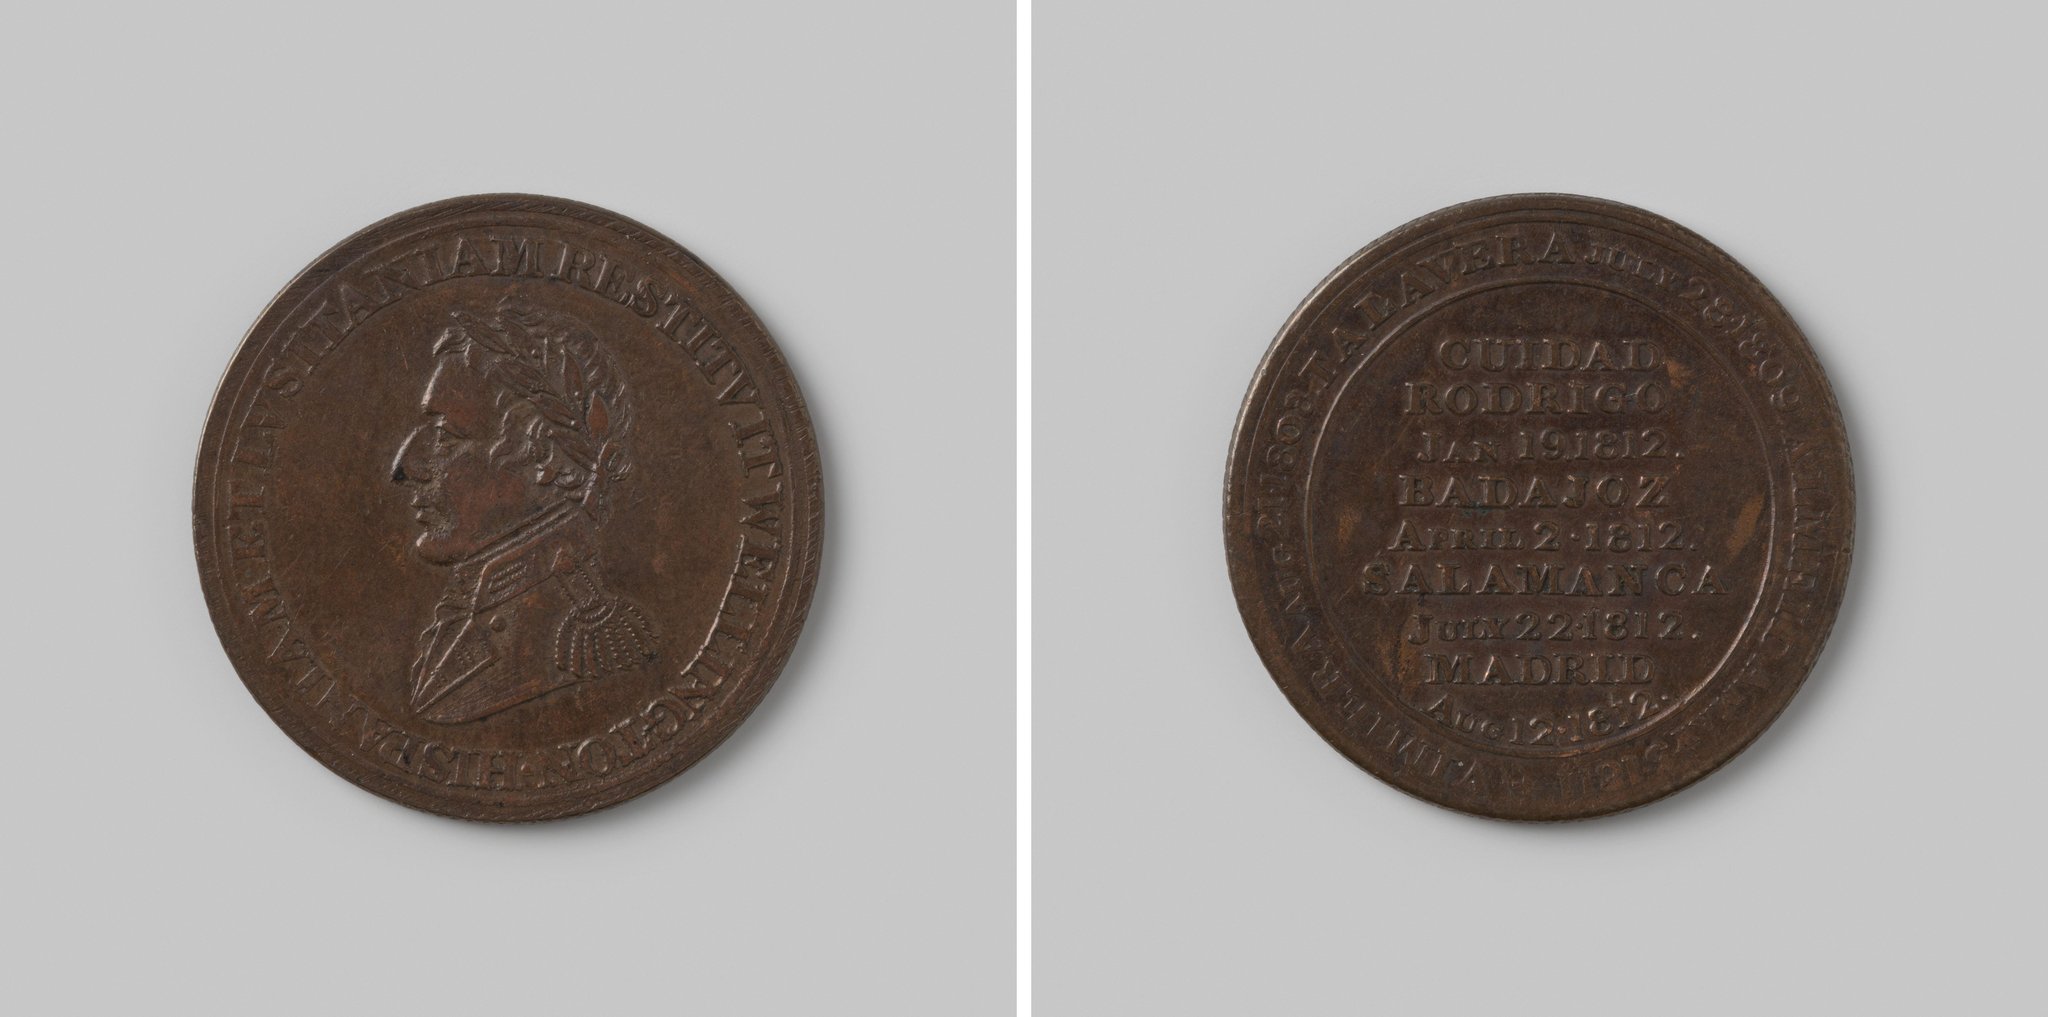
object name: history medal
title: Herstel van Spanje en Portugal door Wellingtons overwinningen 1812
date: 1812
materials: metal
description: Koperen penning, op de voorzijde het borstbeeld van Wellington naar links met omschrift, op de keerzijde negen regels tekst met omschrift, kabelrand.